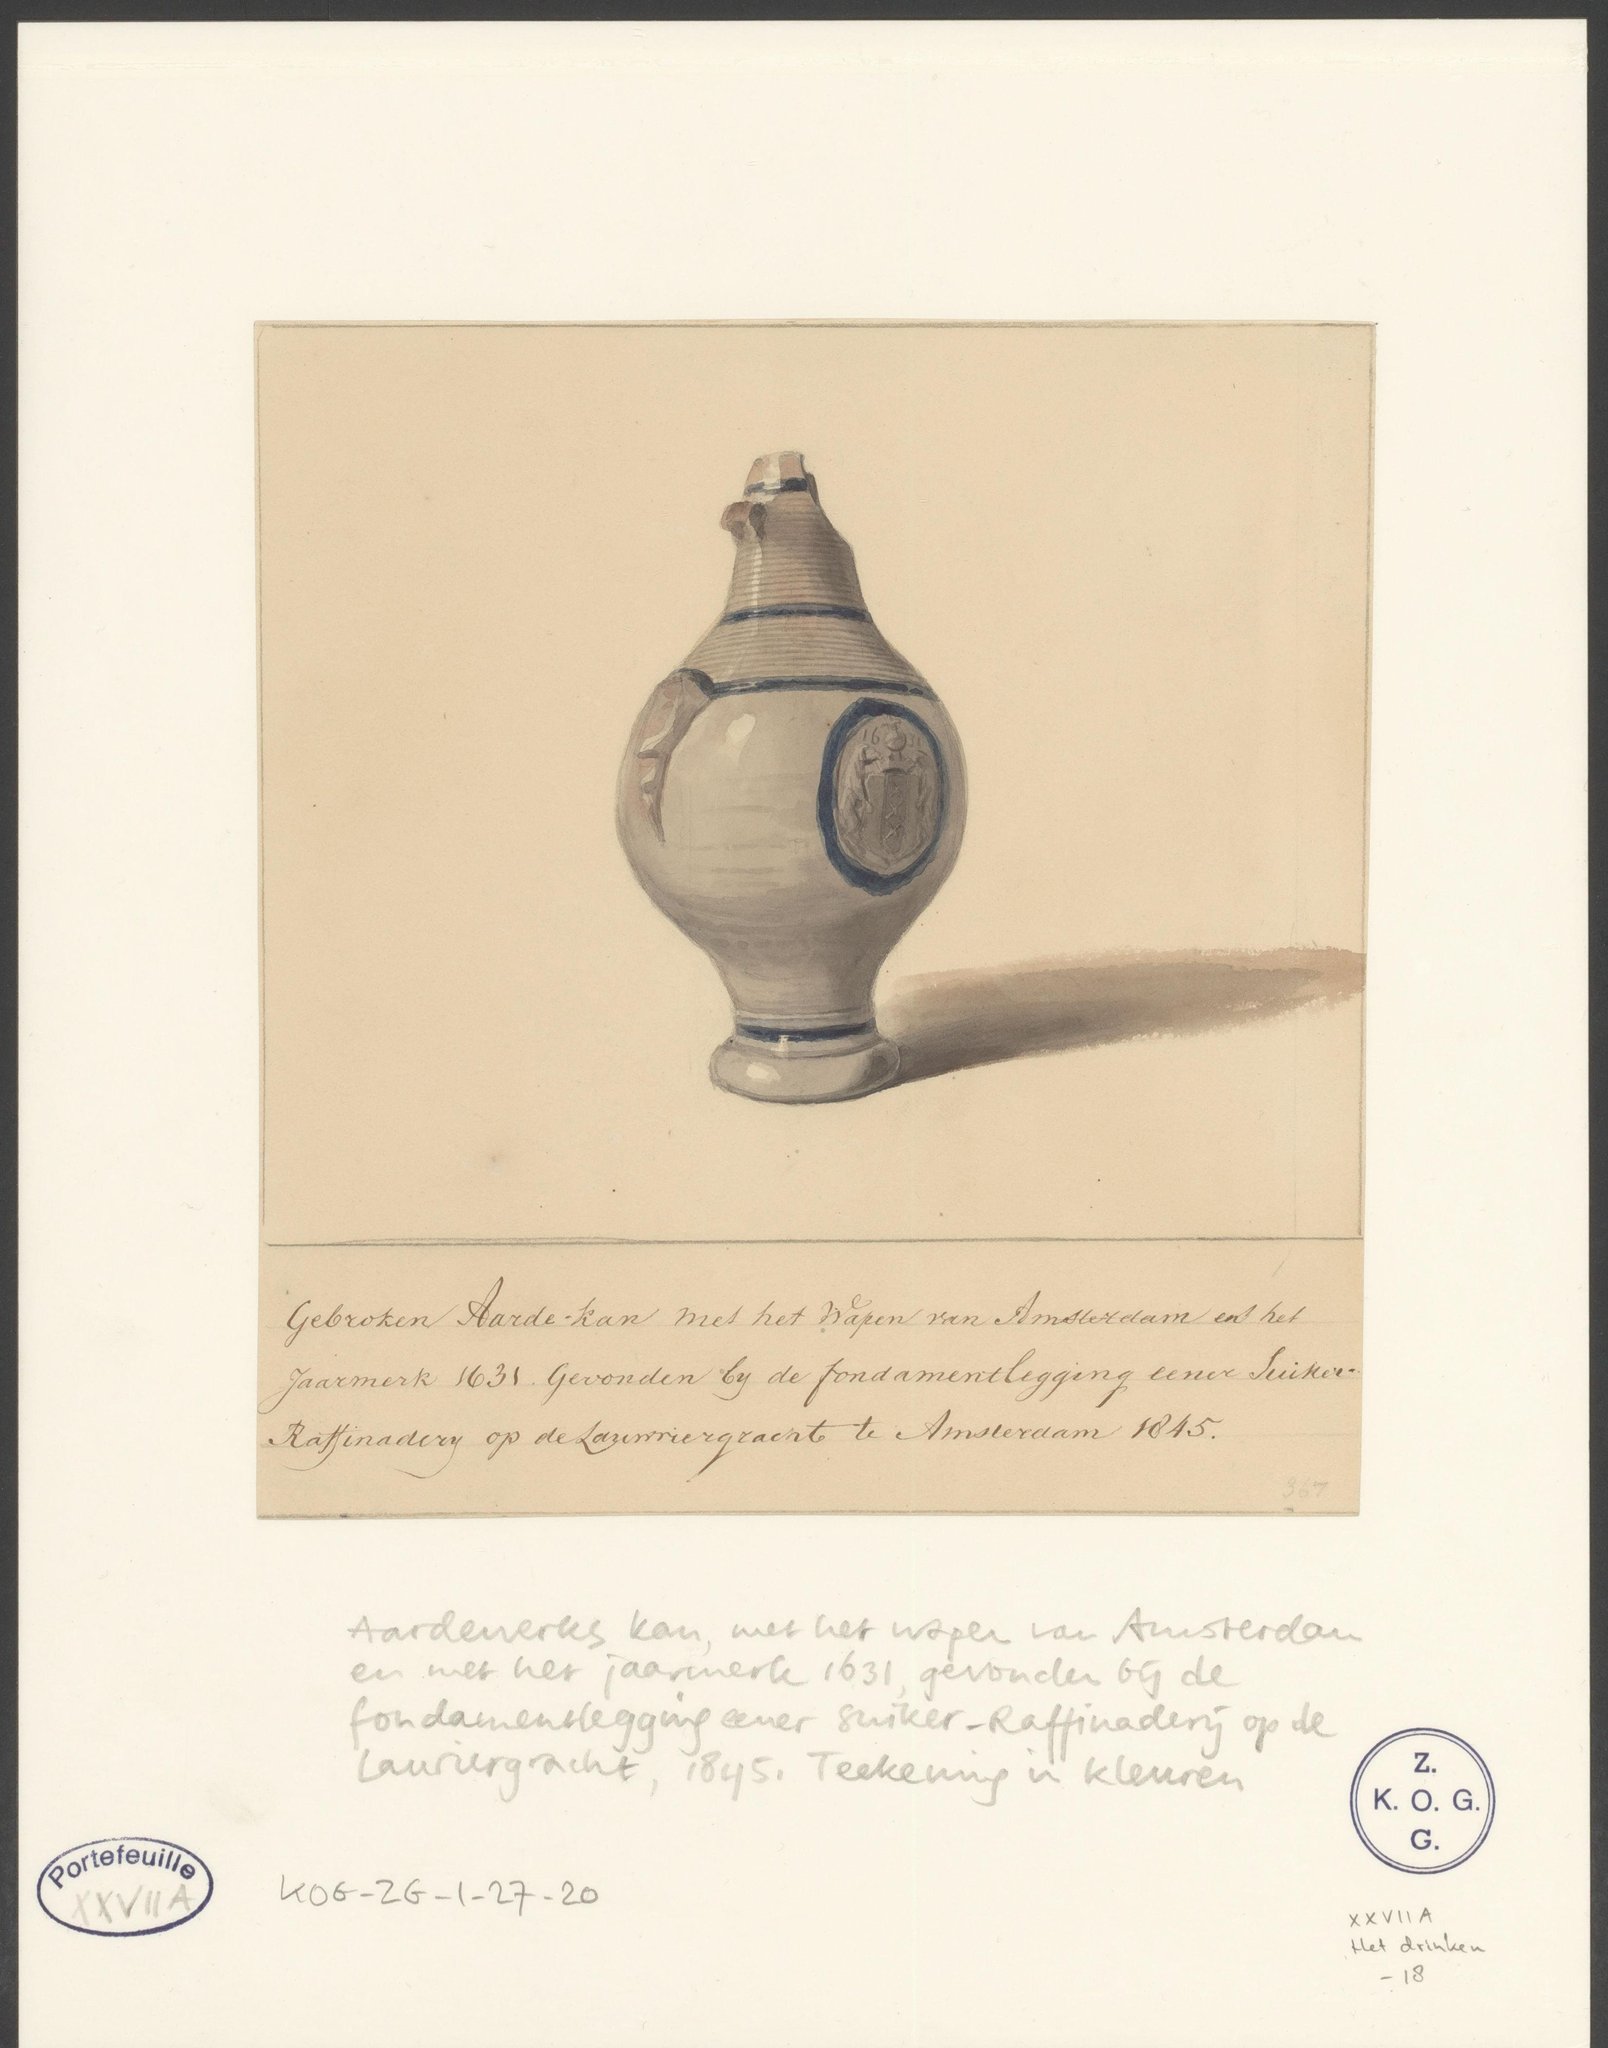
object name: drawing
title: Gebroken Aarde-kan met het wapen van Amsterdam en het jaarmerk 1631. Gevonden (...) 1845.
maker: Anonymous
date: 1845-1899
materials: paper, watercolor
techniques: brush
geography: netherlands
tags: jar, jug (used as drinking-vessel), alcoholic drinks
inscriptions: collector's mark, collector's mark: Lugt 1641